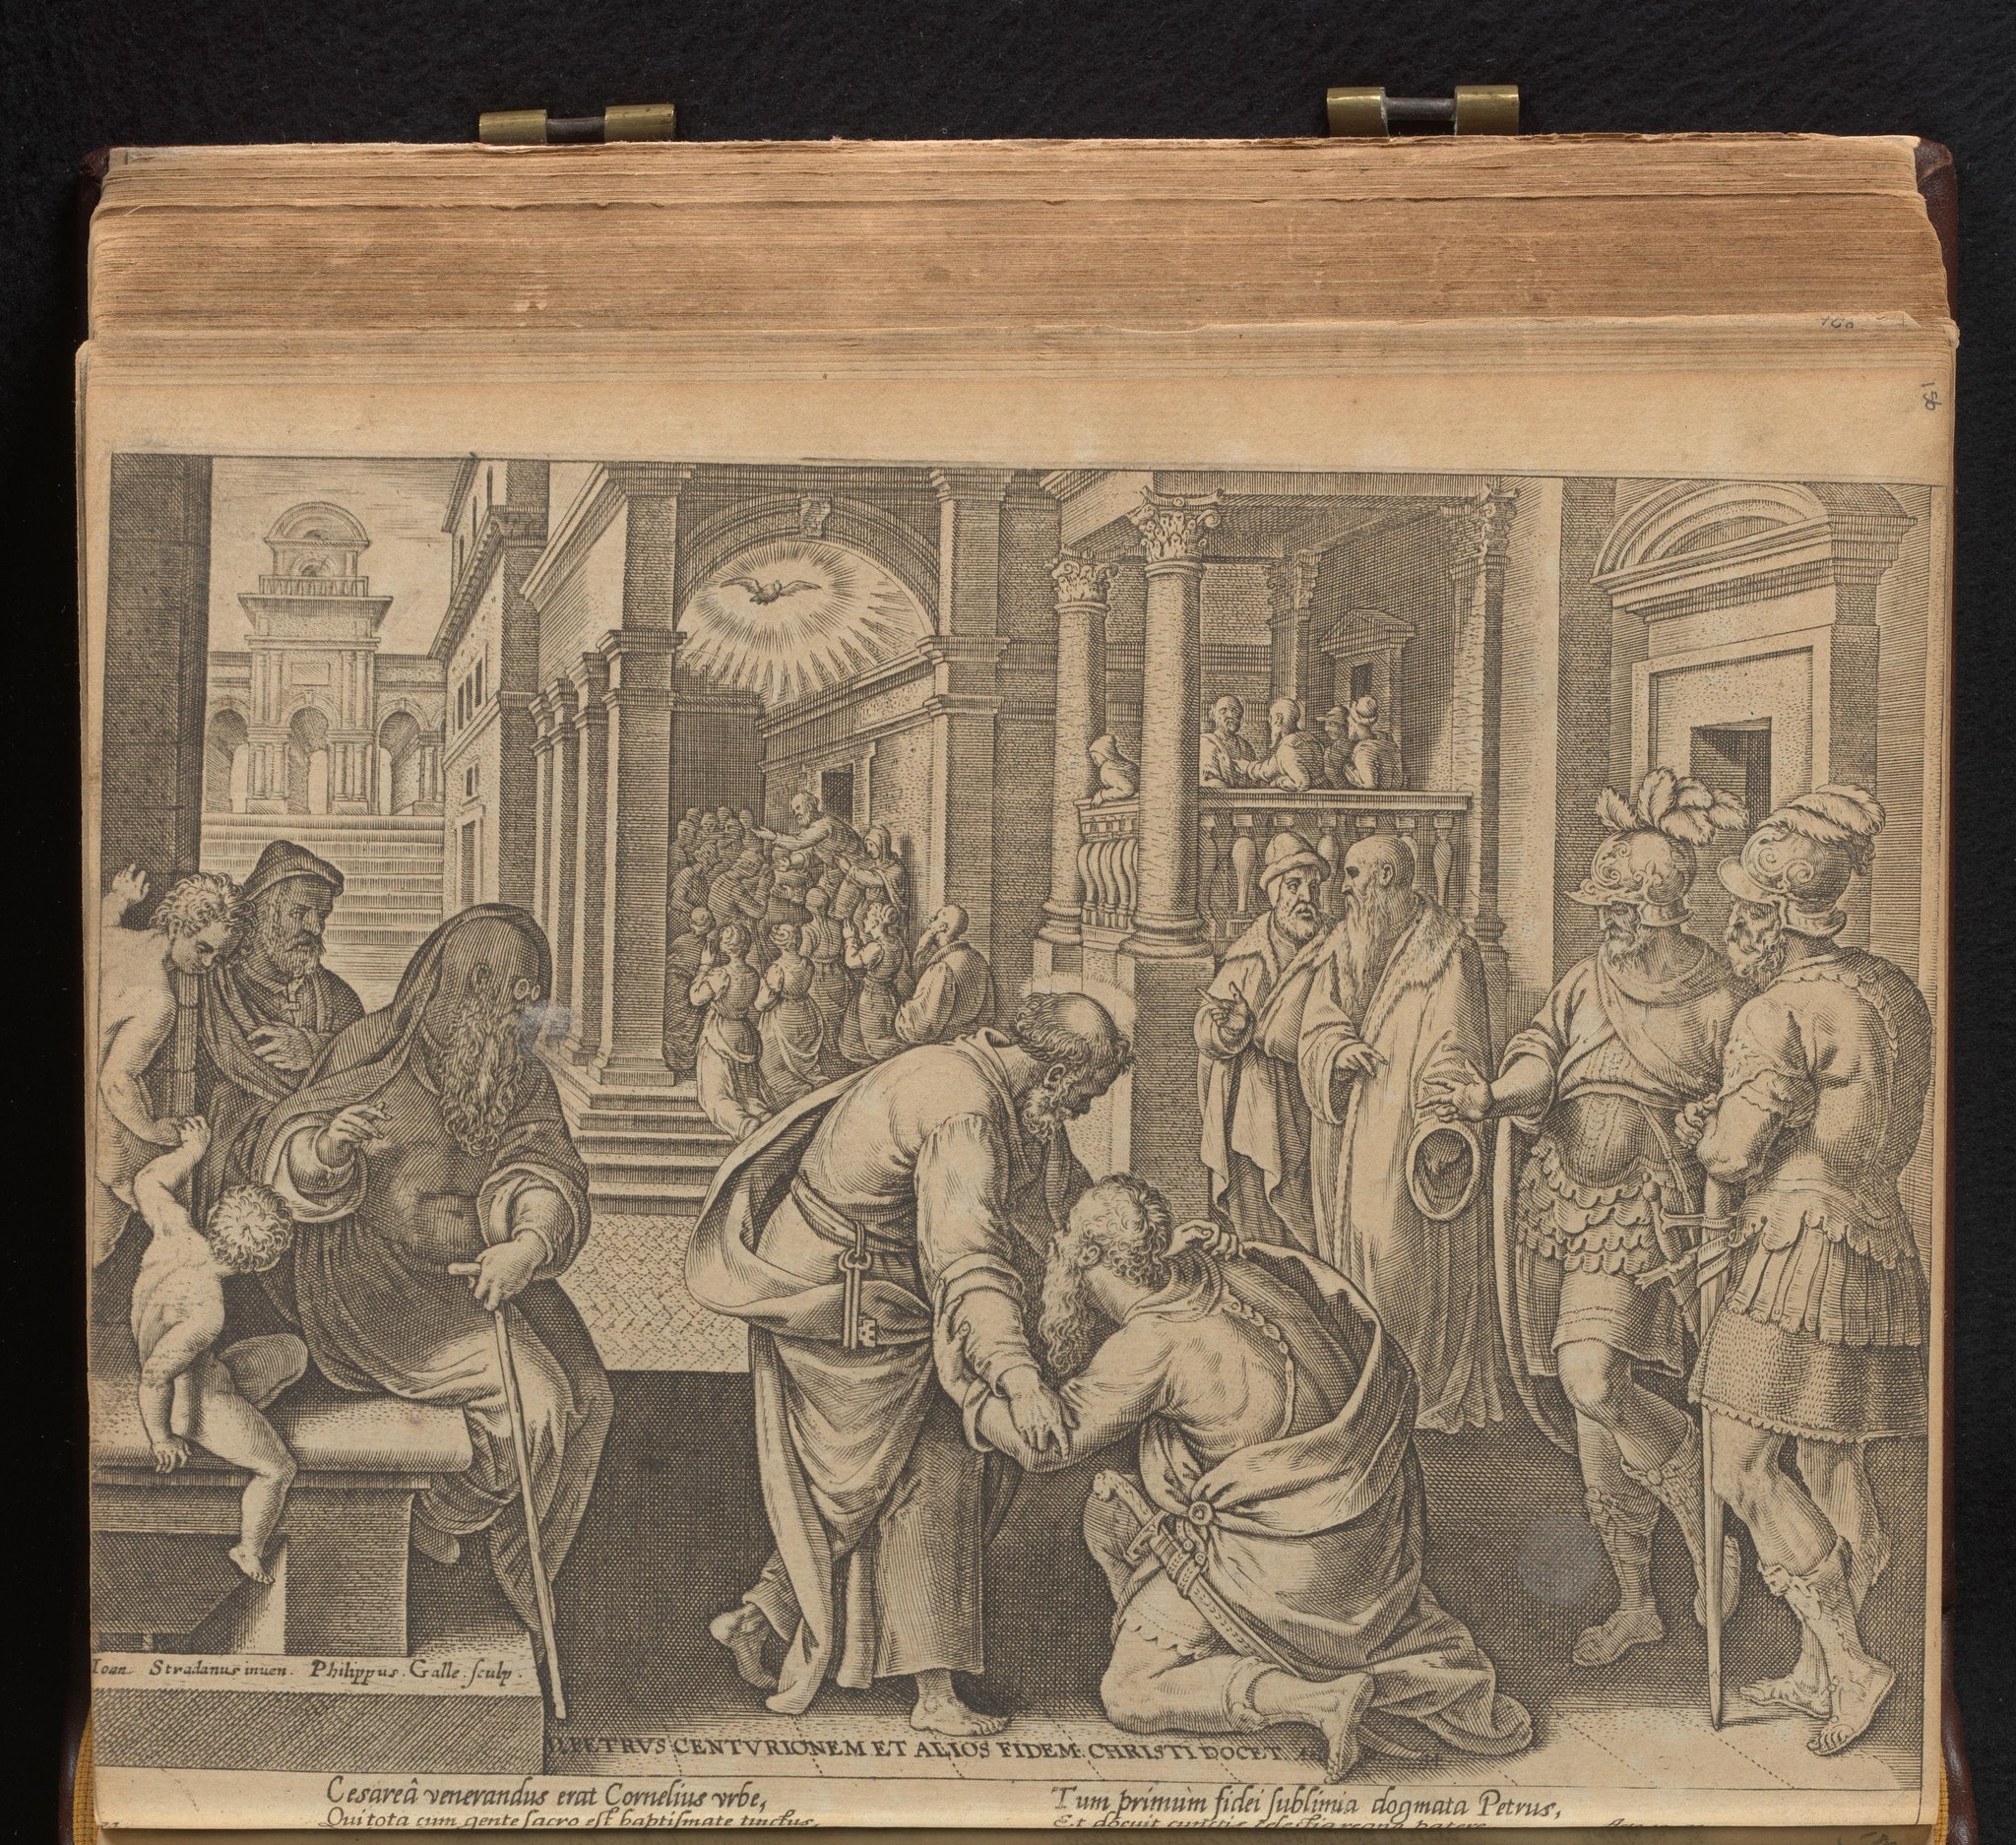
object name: album leaf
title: Acta Apostolorum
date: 1582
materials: paper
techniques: engraving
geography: antwerp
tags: peter in the house of cornelius: the holy ghost descends upon cornelius and his family, who are baptized by peter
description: Prent maakt deel uit van een prentbijbel.